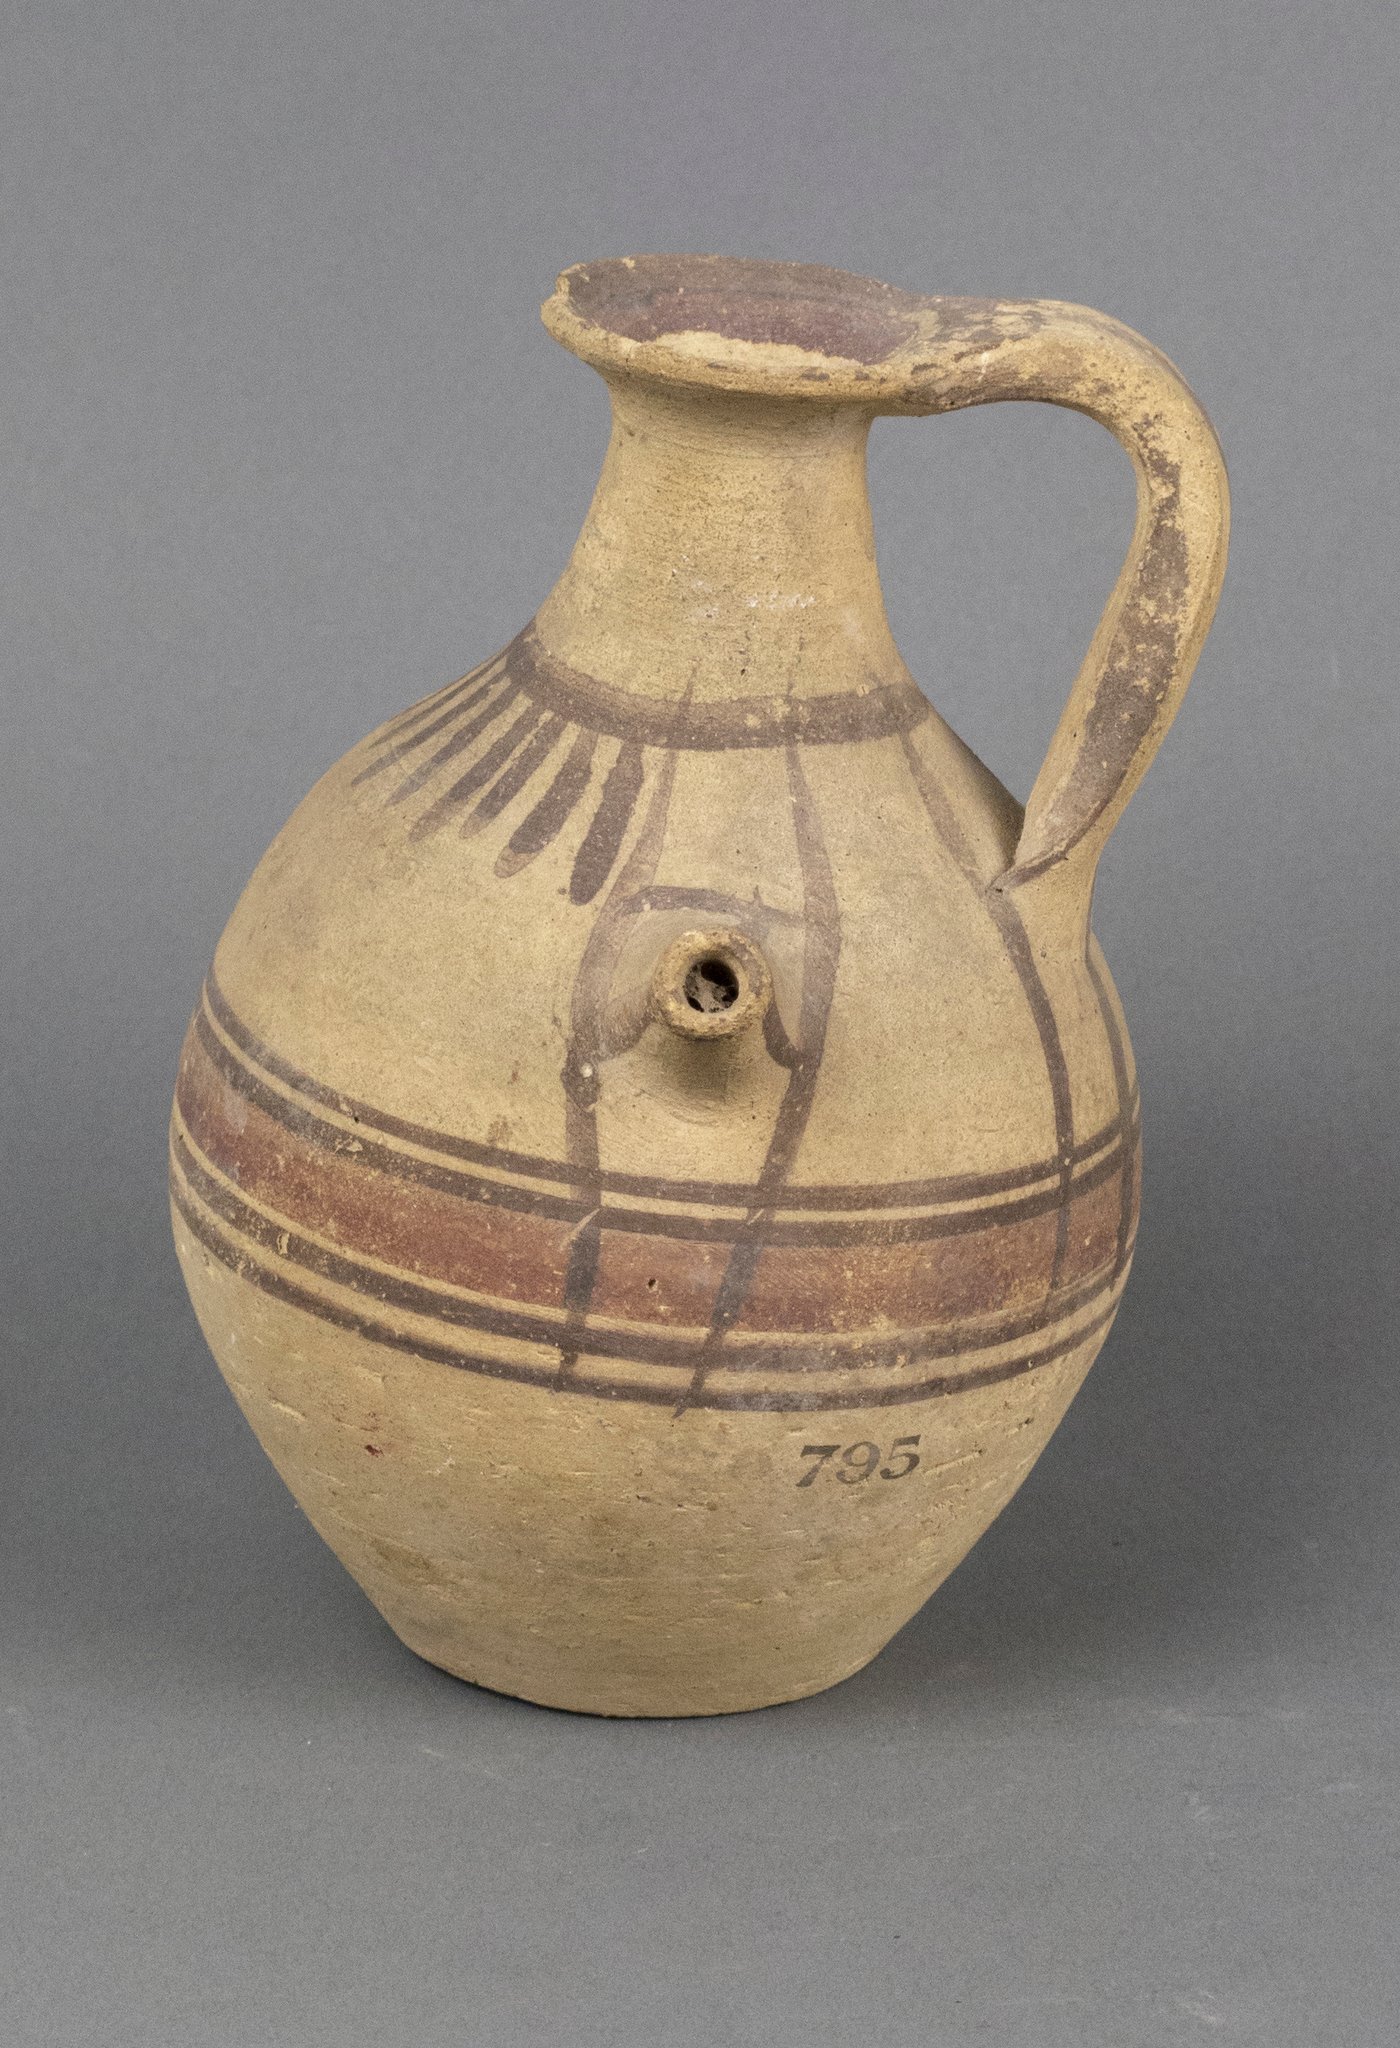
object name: jug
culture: cypriot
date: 600-480 BCE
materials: terracotta